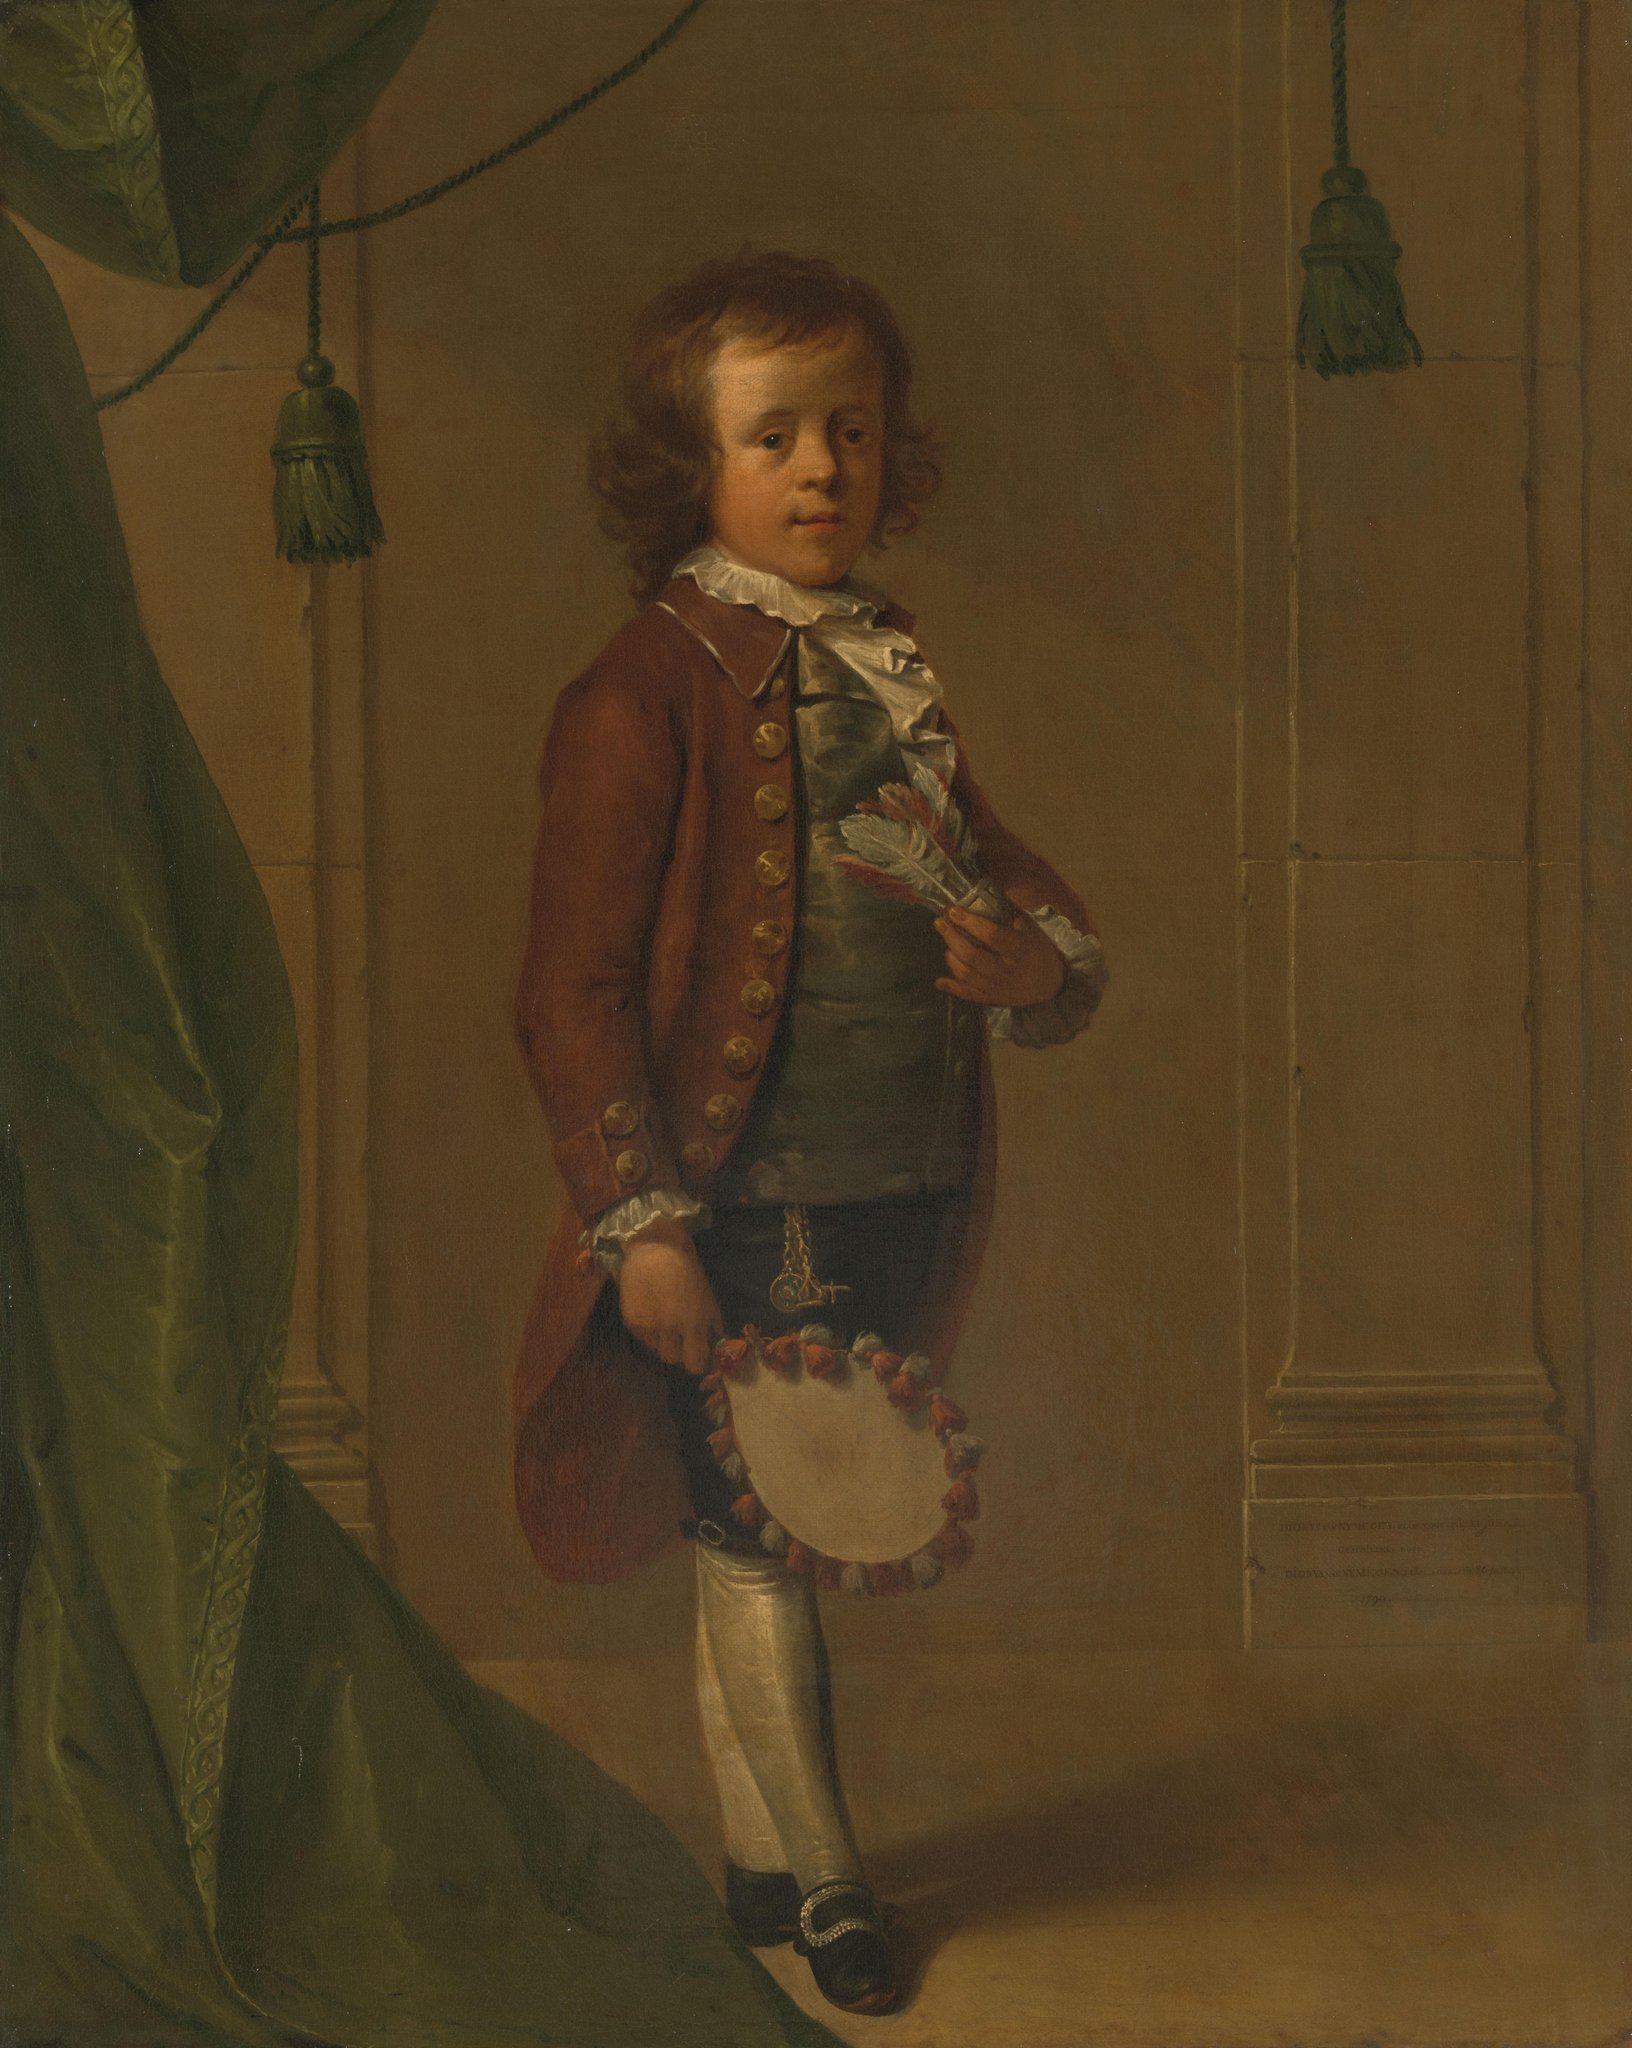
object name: painting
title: Portrait of Dionys Eliasz van Nijmegen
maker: dionys van nijmegen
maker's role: draughtsman, painter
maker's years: 1705-1798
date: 1790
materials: canvas, oil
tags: child, 'jeu de volant', badminton, historical persons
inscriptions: inscription: ‘Dionijs van Nijmegen Eliaszoon oud XI jaren geschildert door Dionijs van Nijmegen Eliaszoon oud 86 jaren, 1790’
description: Rotterdam painter Dionys van Nijmegen was 86 when he portrayed his 11-year-old grandson, as he noted on the base of the pilaster. Judging from the fine detailing of the sitter’s clothing, the aged painter’s eyesight was still excellent. The boy holds a racket and a shuttlecock. He grew up to become a physician.